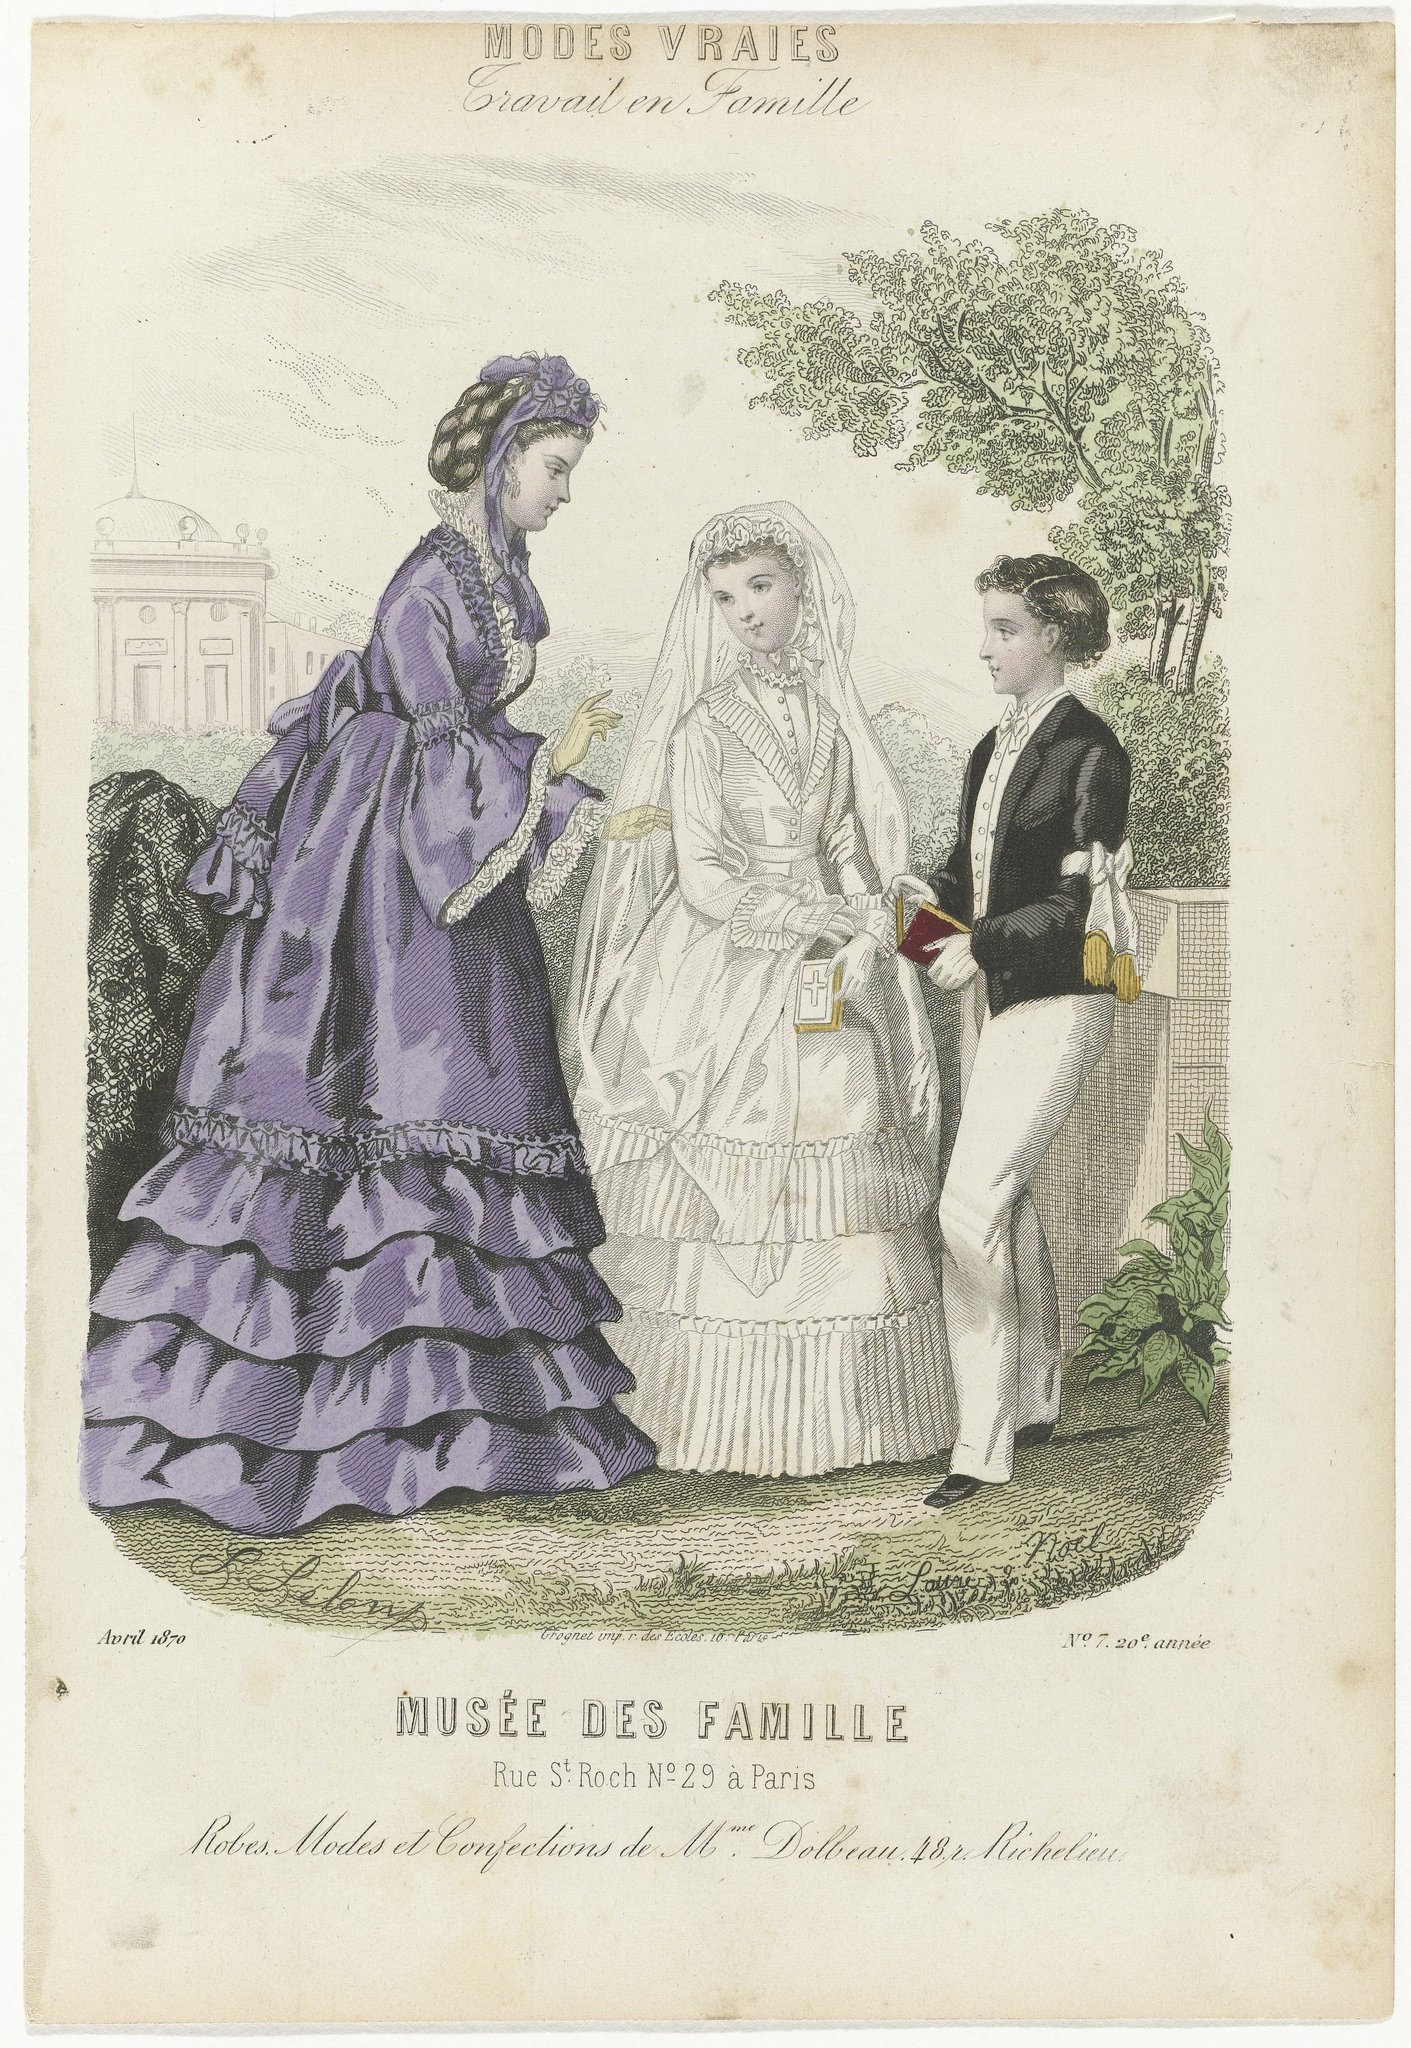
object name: fashion print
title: Musée des Familles, april 1870, No. 7, 20e année : Robes Modes et Confections (...)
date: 1870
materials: paper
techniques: engraving, hand coloring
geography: paris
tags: trousers, breeches (+ boys' clothes), gloves, mittens, etc. (+ boys' clothes), communion dress, veil (+ girls' clothes), coat (+ boys' clothes), head-gear (+ women's clothes), fashion plates, gloves, mittens, etc. (+ women's clothes), dress, gown (+ women's clothes), the bible as a book, dress, gown (+ girls' clothes)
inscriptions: caption: ‘Robes Modes et Confections de Mme Dolbeau 48 r. Richelieu’, title: ‘Musée des Familles’, title: ‘Modes Vraies / Travail en famille.’, address: ‘Rue S.t Roch, No. 29 / Paris’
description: Een vrouw en twee kinderen staan buiten, zij zijn gekleed in kleding van Dolbeau. Prent uit het modetijdschrift Musée des Familles (1833-1874).